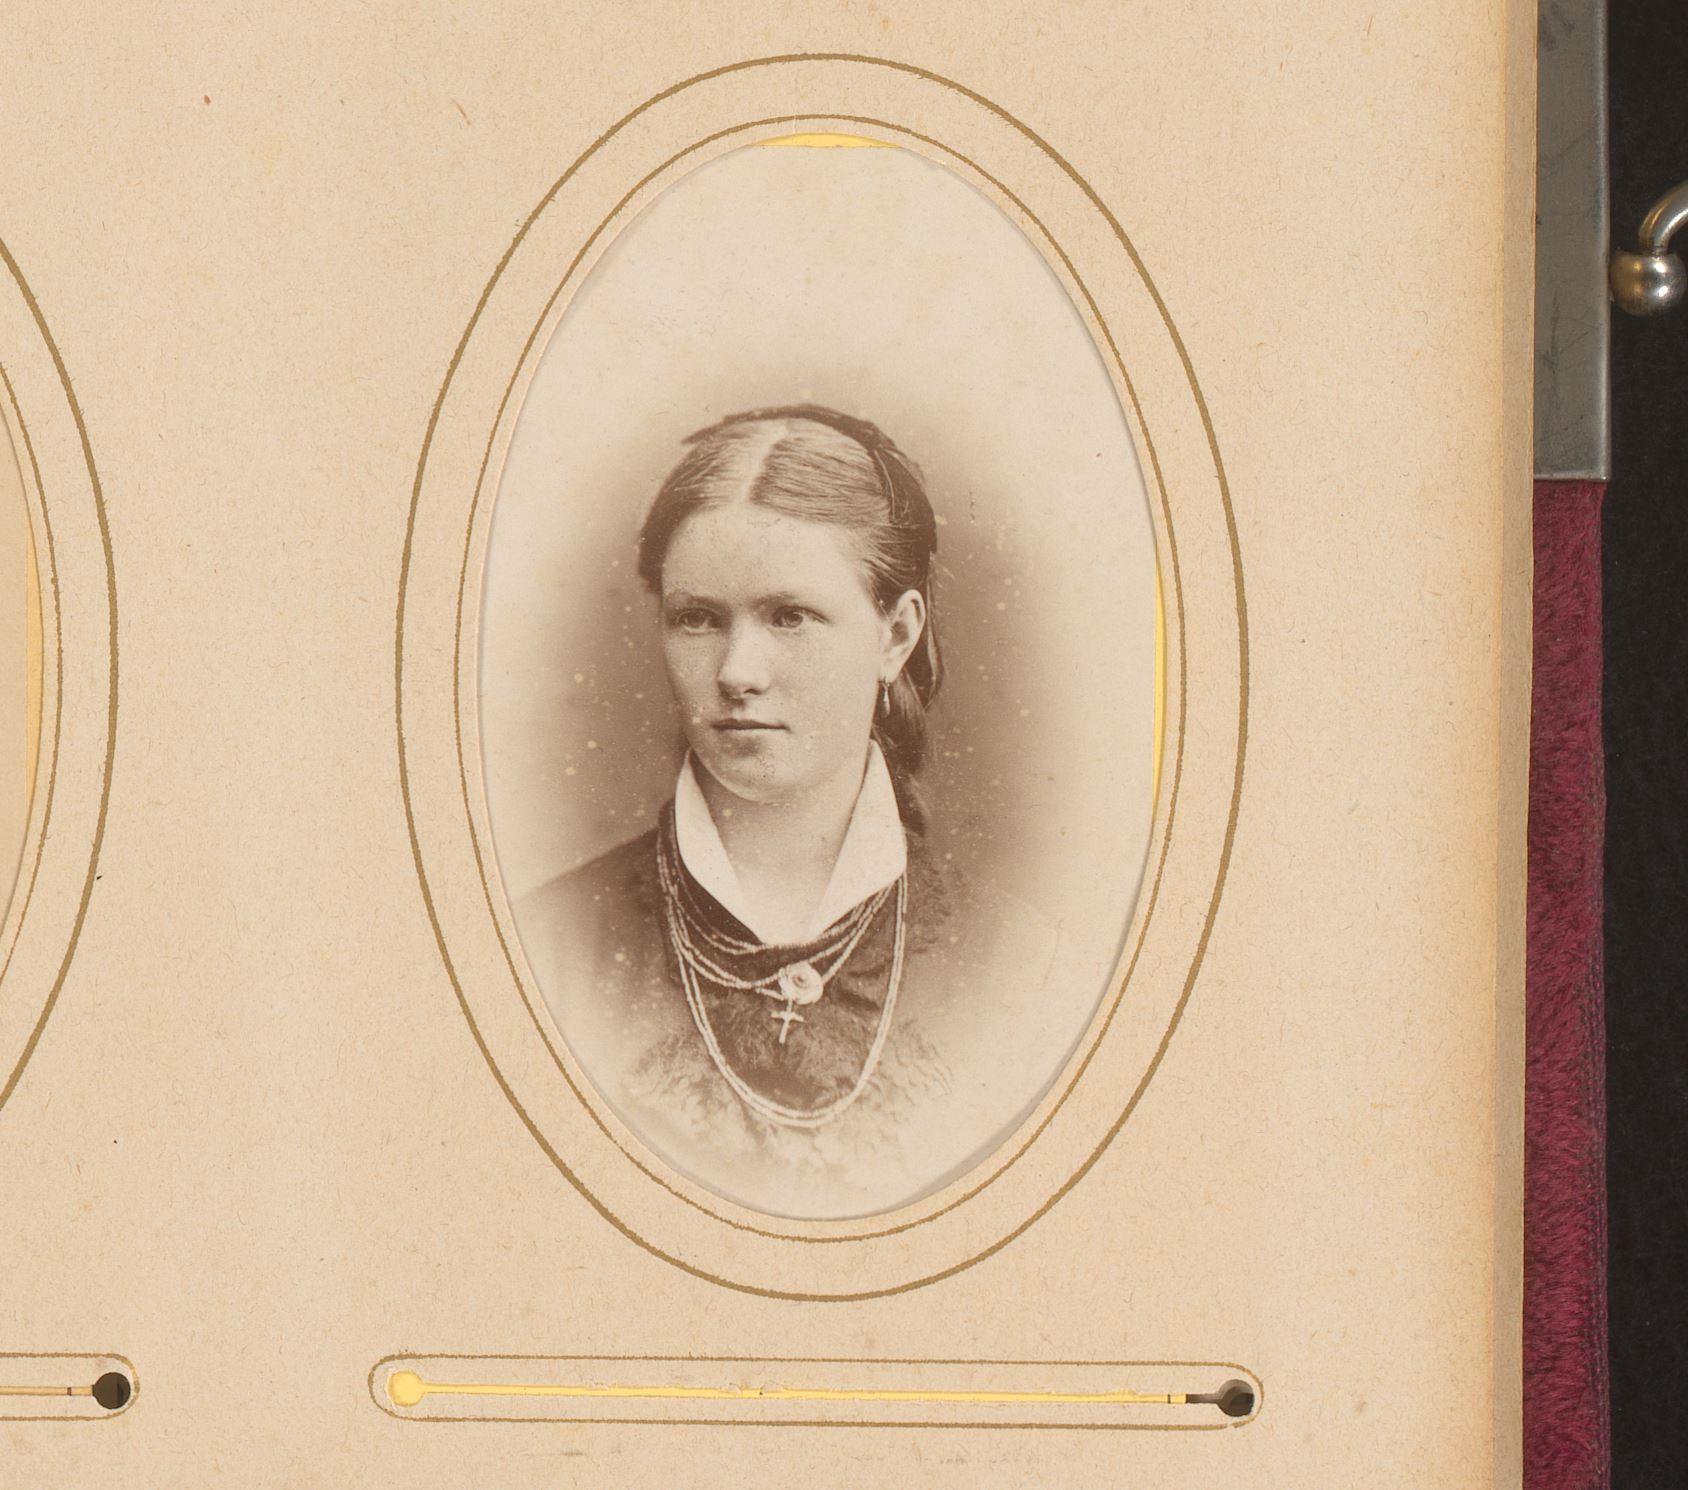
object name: album leaf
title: Portret van een jonge vrouw met ketting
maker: friedrich julius von kolkow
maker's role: fotograaf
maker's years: 1839-1914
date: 1876-1900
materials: cardboard, photographic support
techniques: albumen print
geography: groningen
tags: adolescent, young woman, maiden, necklace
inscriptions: inscription: ‘Philadelphia 1876/ 1873 (...) Fr. Jul. von Kolkow/ Hof-Photograph/ Z.K.H. Prins Hendrik der Nederlanden/ Groningen’